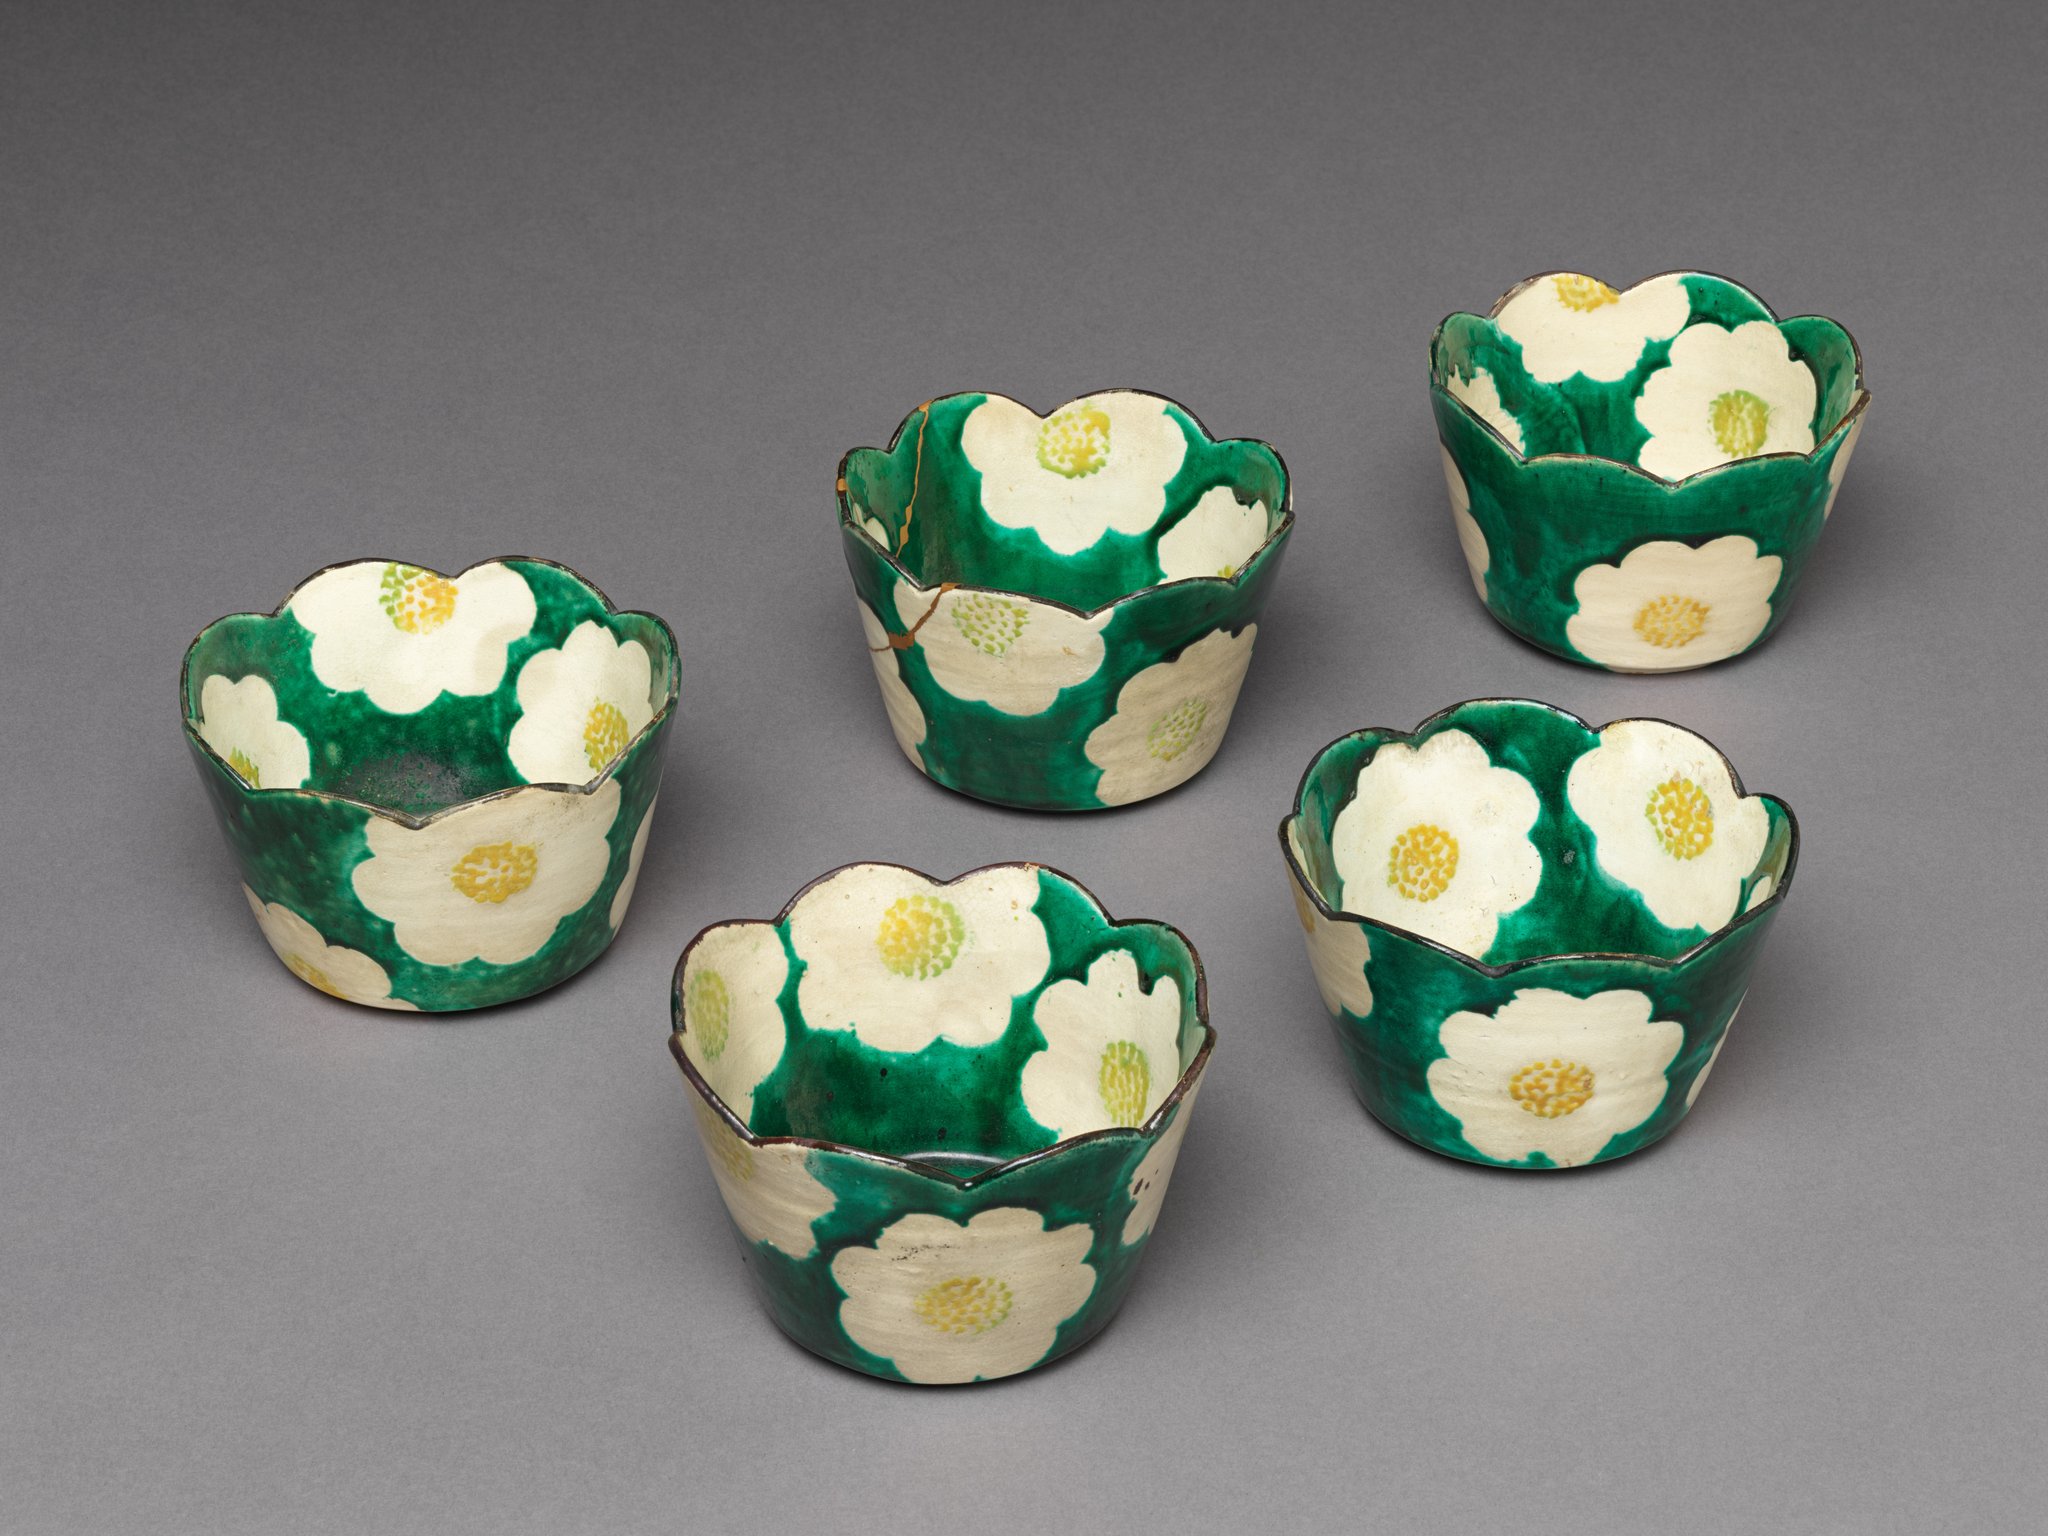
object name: vessel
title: Set of Five Camellia-Shaped Side Dishes (Mukōzuke) with Camellia Patterns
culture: japanese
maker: ogata kenzan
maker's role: artist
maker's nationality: japanese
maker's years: 1663-1743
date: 1701-1800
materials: enamel, stoneware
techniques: overglaze, polychrome